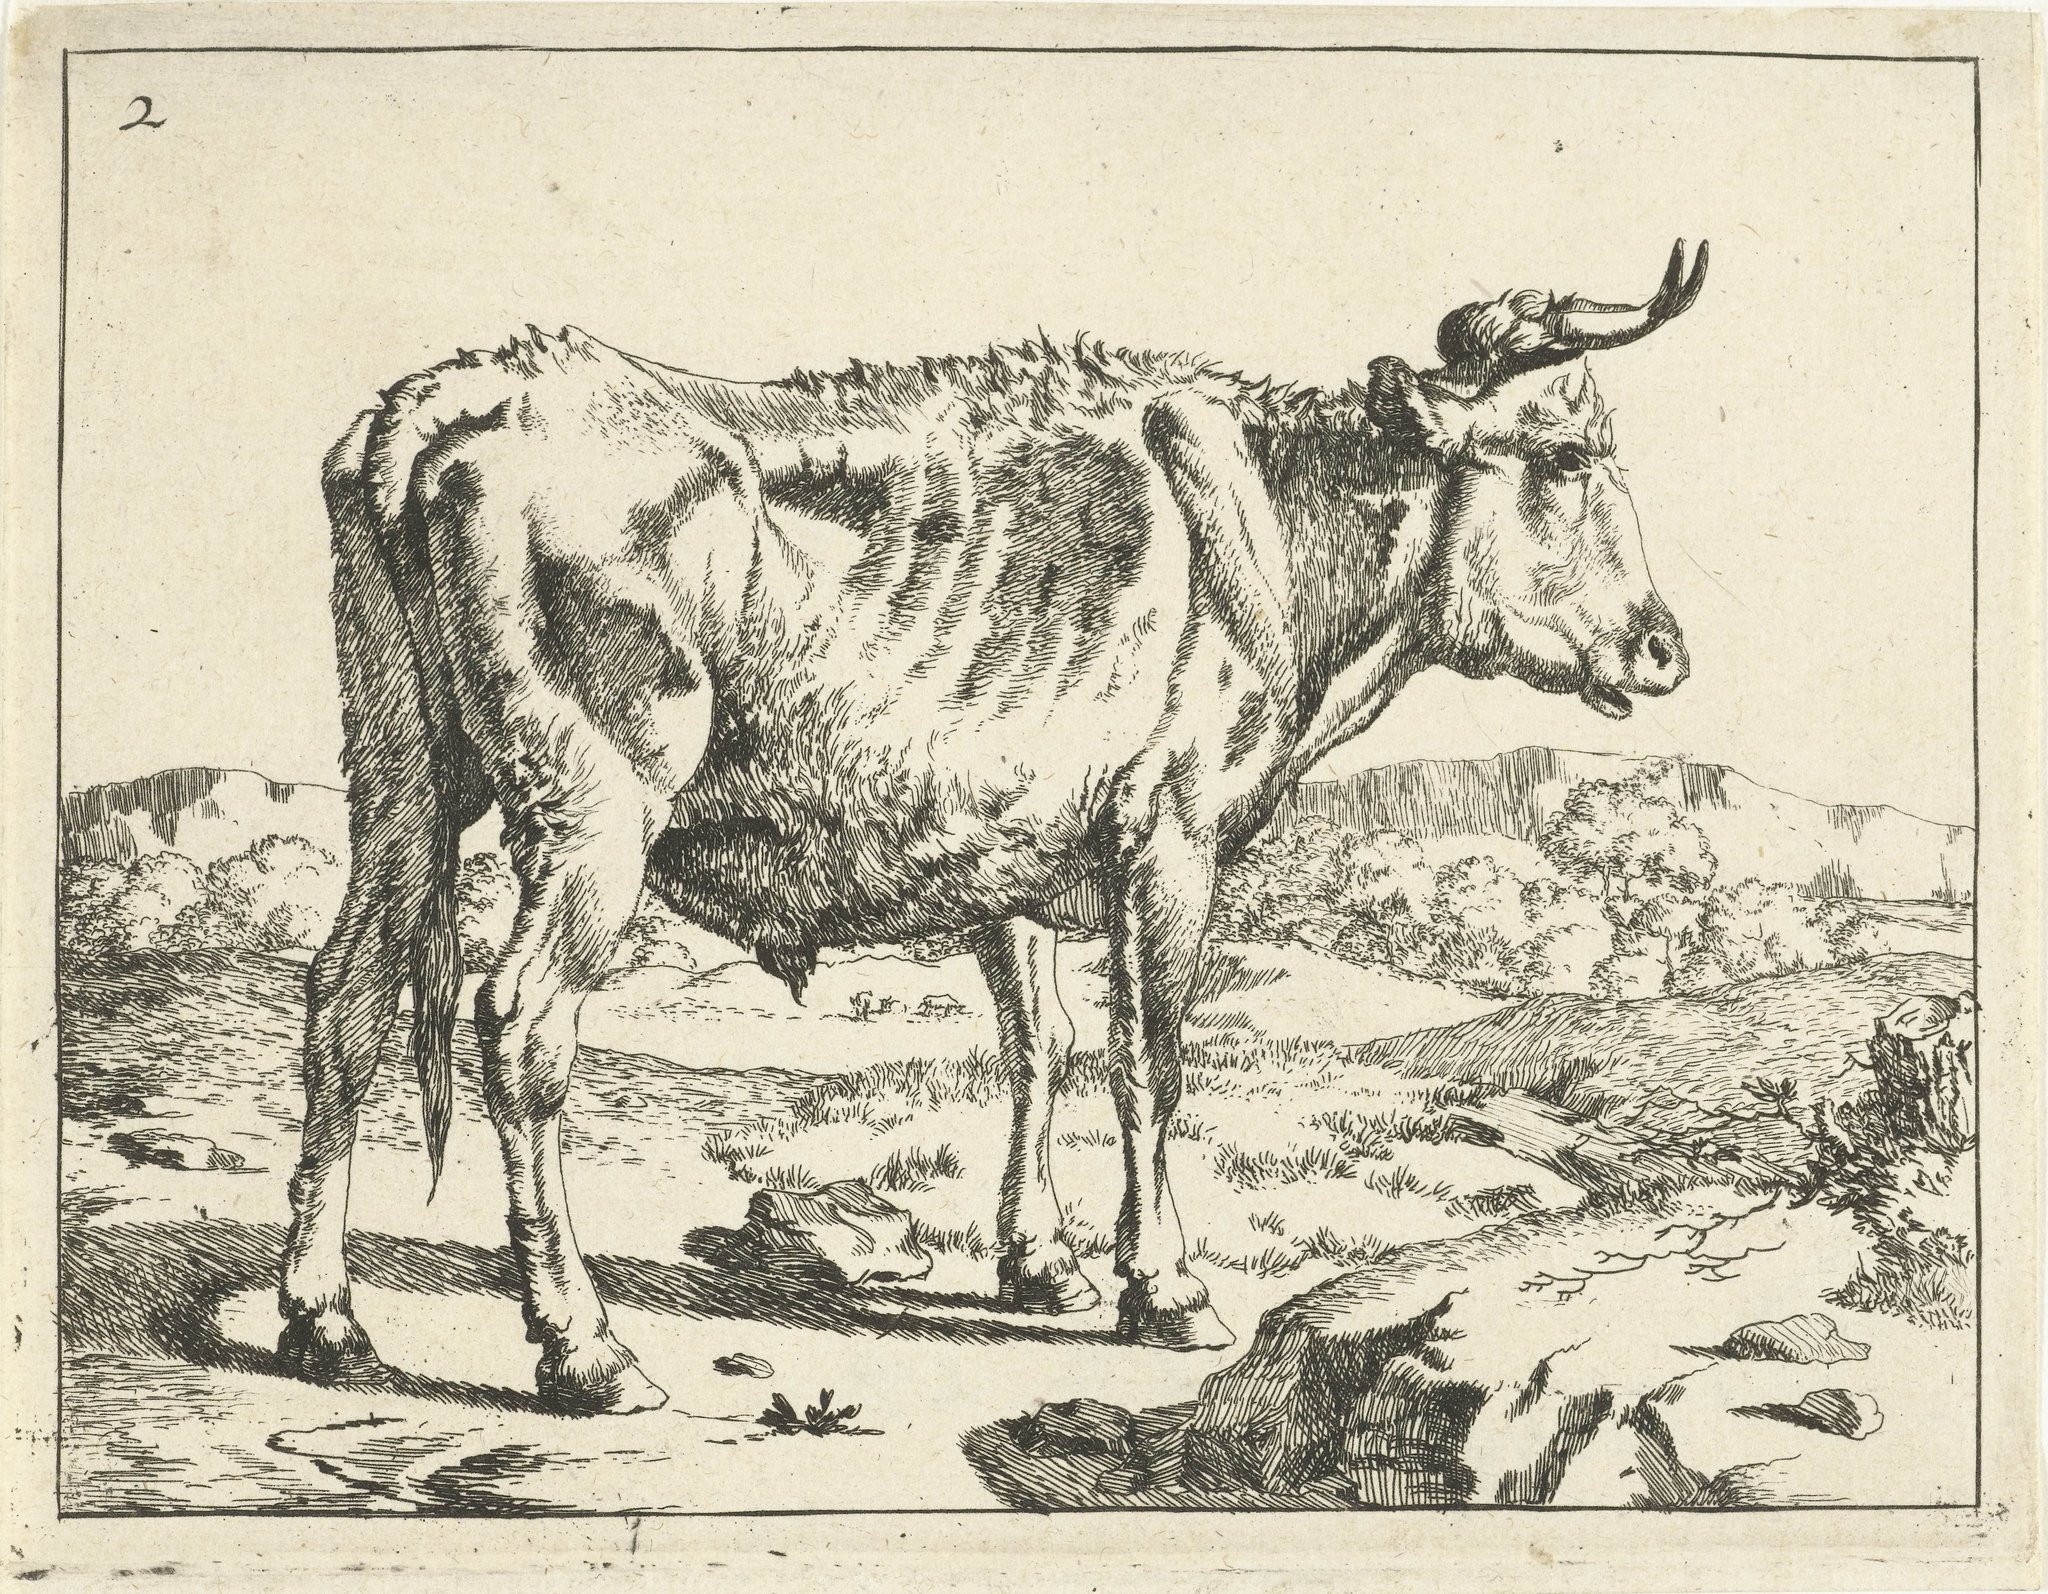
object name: print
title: Stier staand bij rots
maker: marcus de bye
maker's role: print maker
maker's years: 1639-1688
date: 1657-1677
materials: paper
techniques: etching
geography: the hague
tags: cow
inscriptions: collector's mark: Lugt 2228